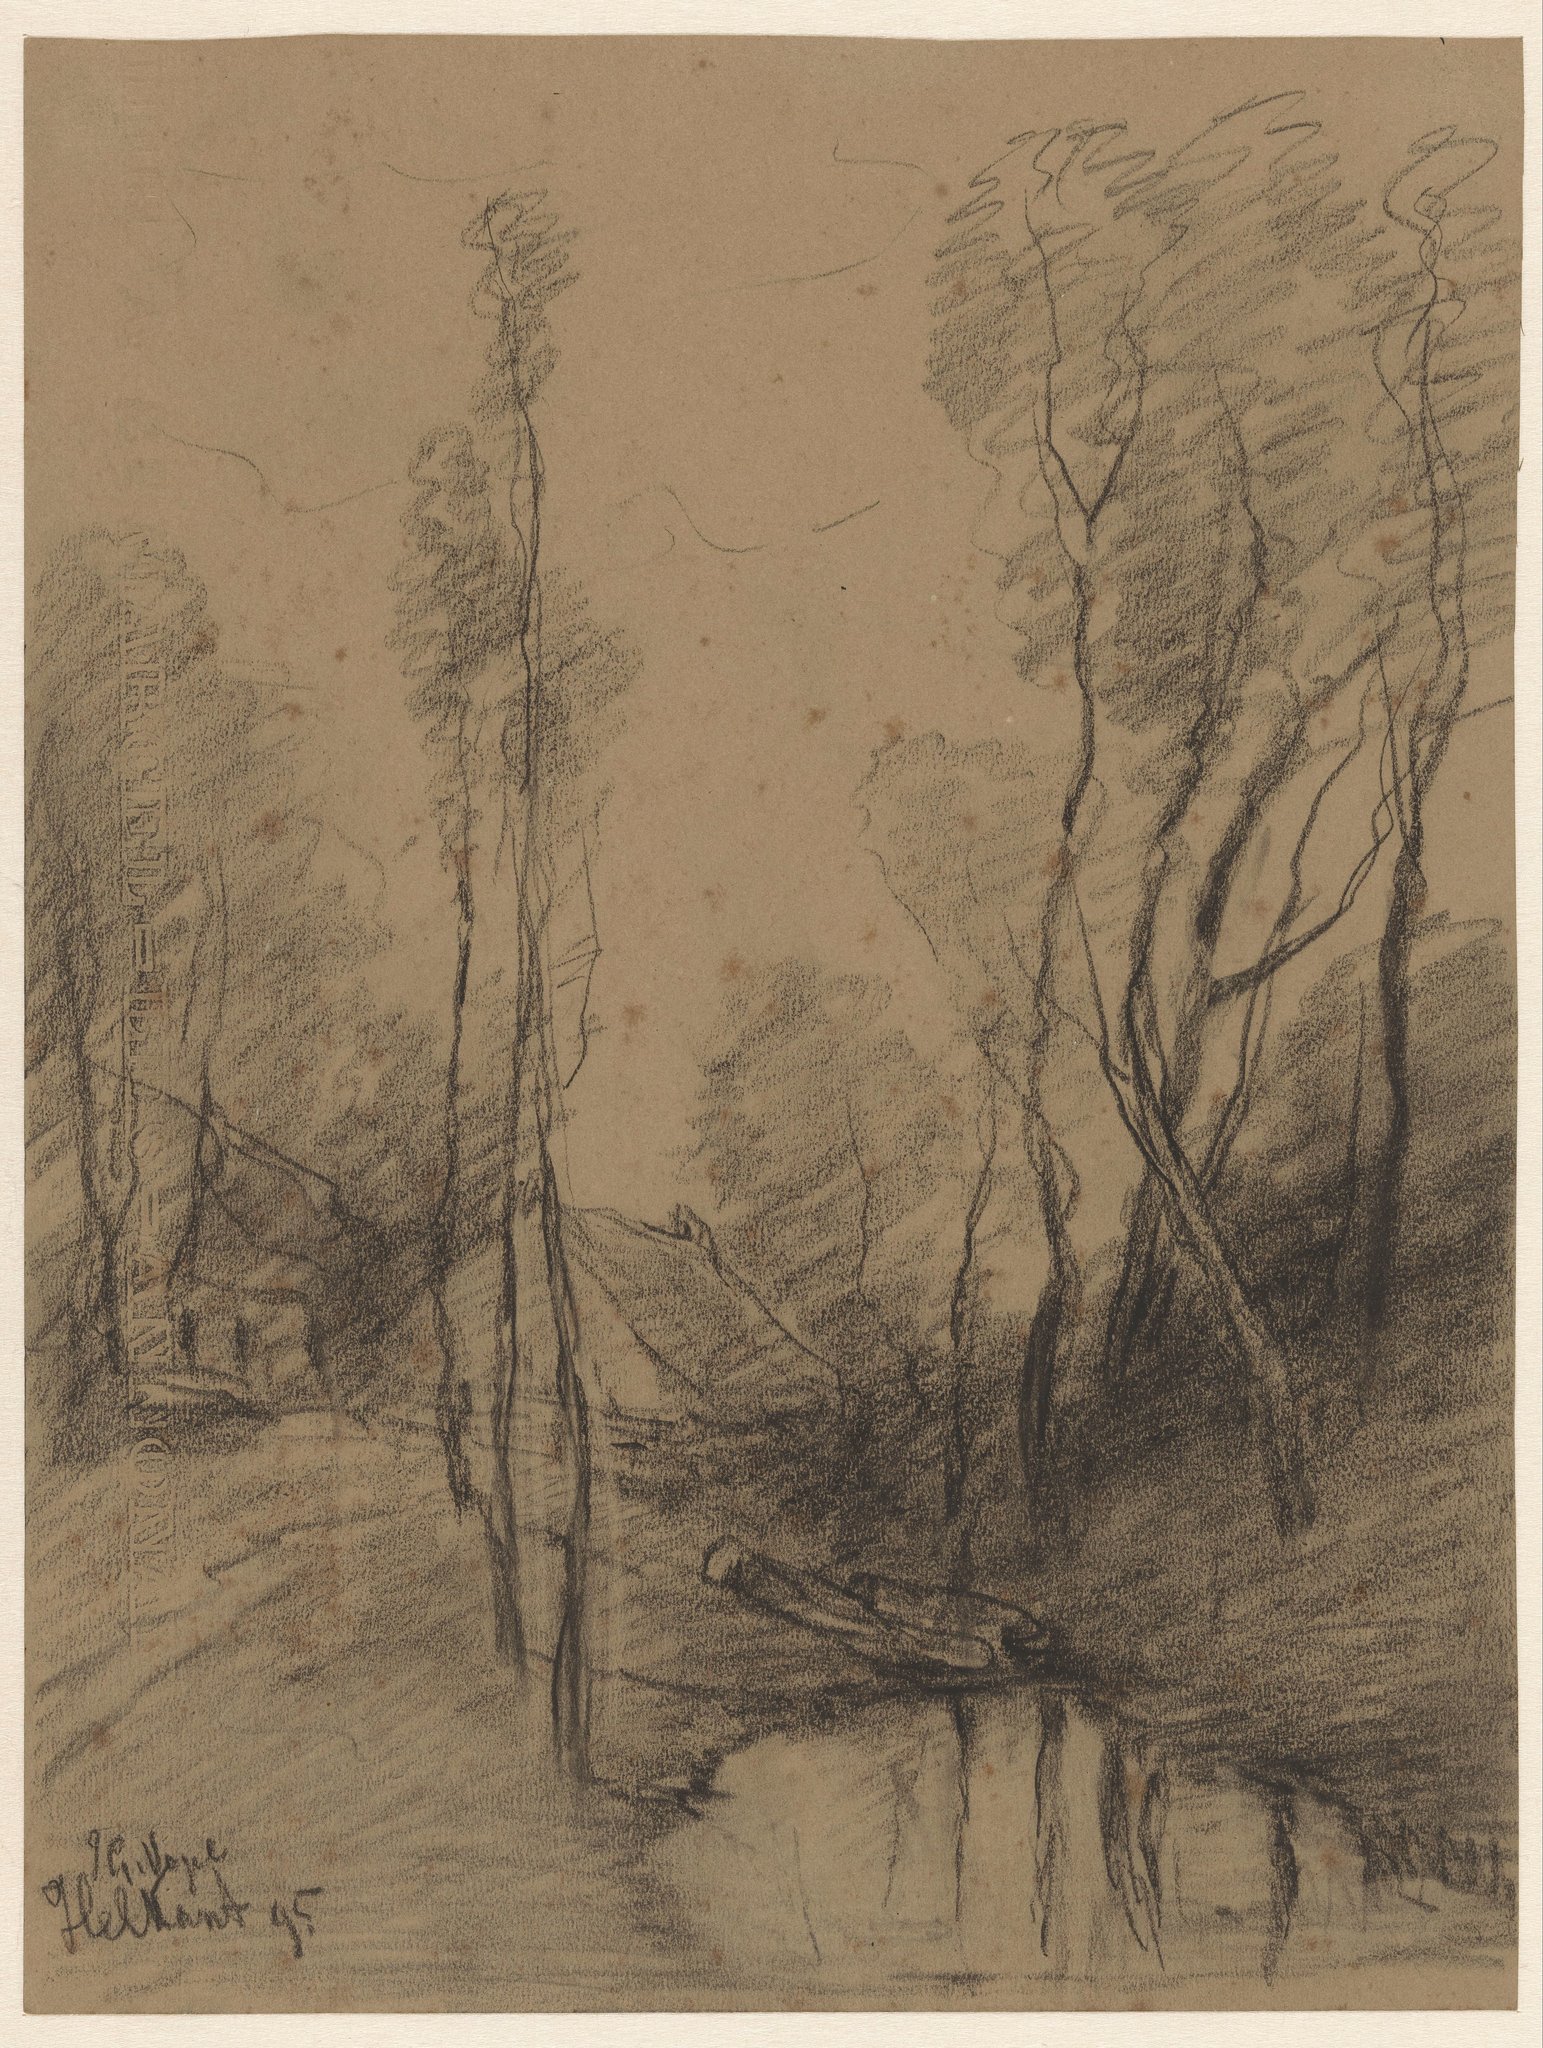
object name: drawing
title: Huizen tussen berkenbomen in Helkant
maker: johannes gijsbert vogel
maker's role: draughtsman, painter, print maker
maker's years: 1828-1915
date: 1895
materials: chalk, paper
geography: helkant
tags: farm or solitary house in landscape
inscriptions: date